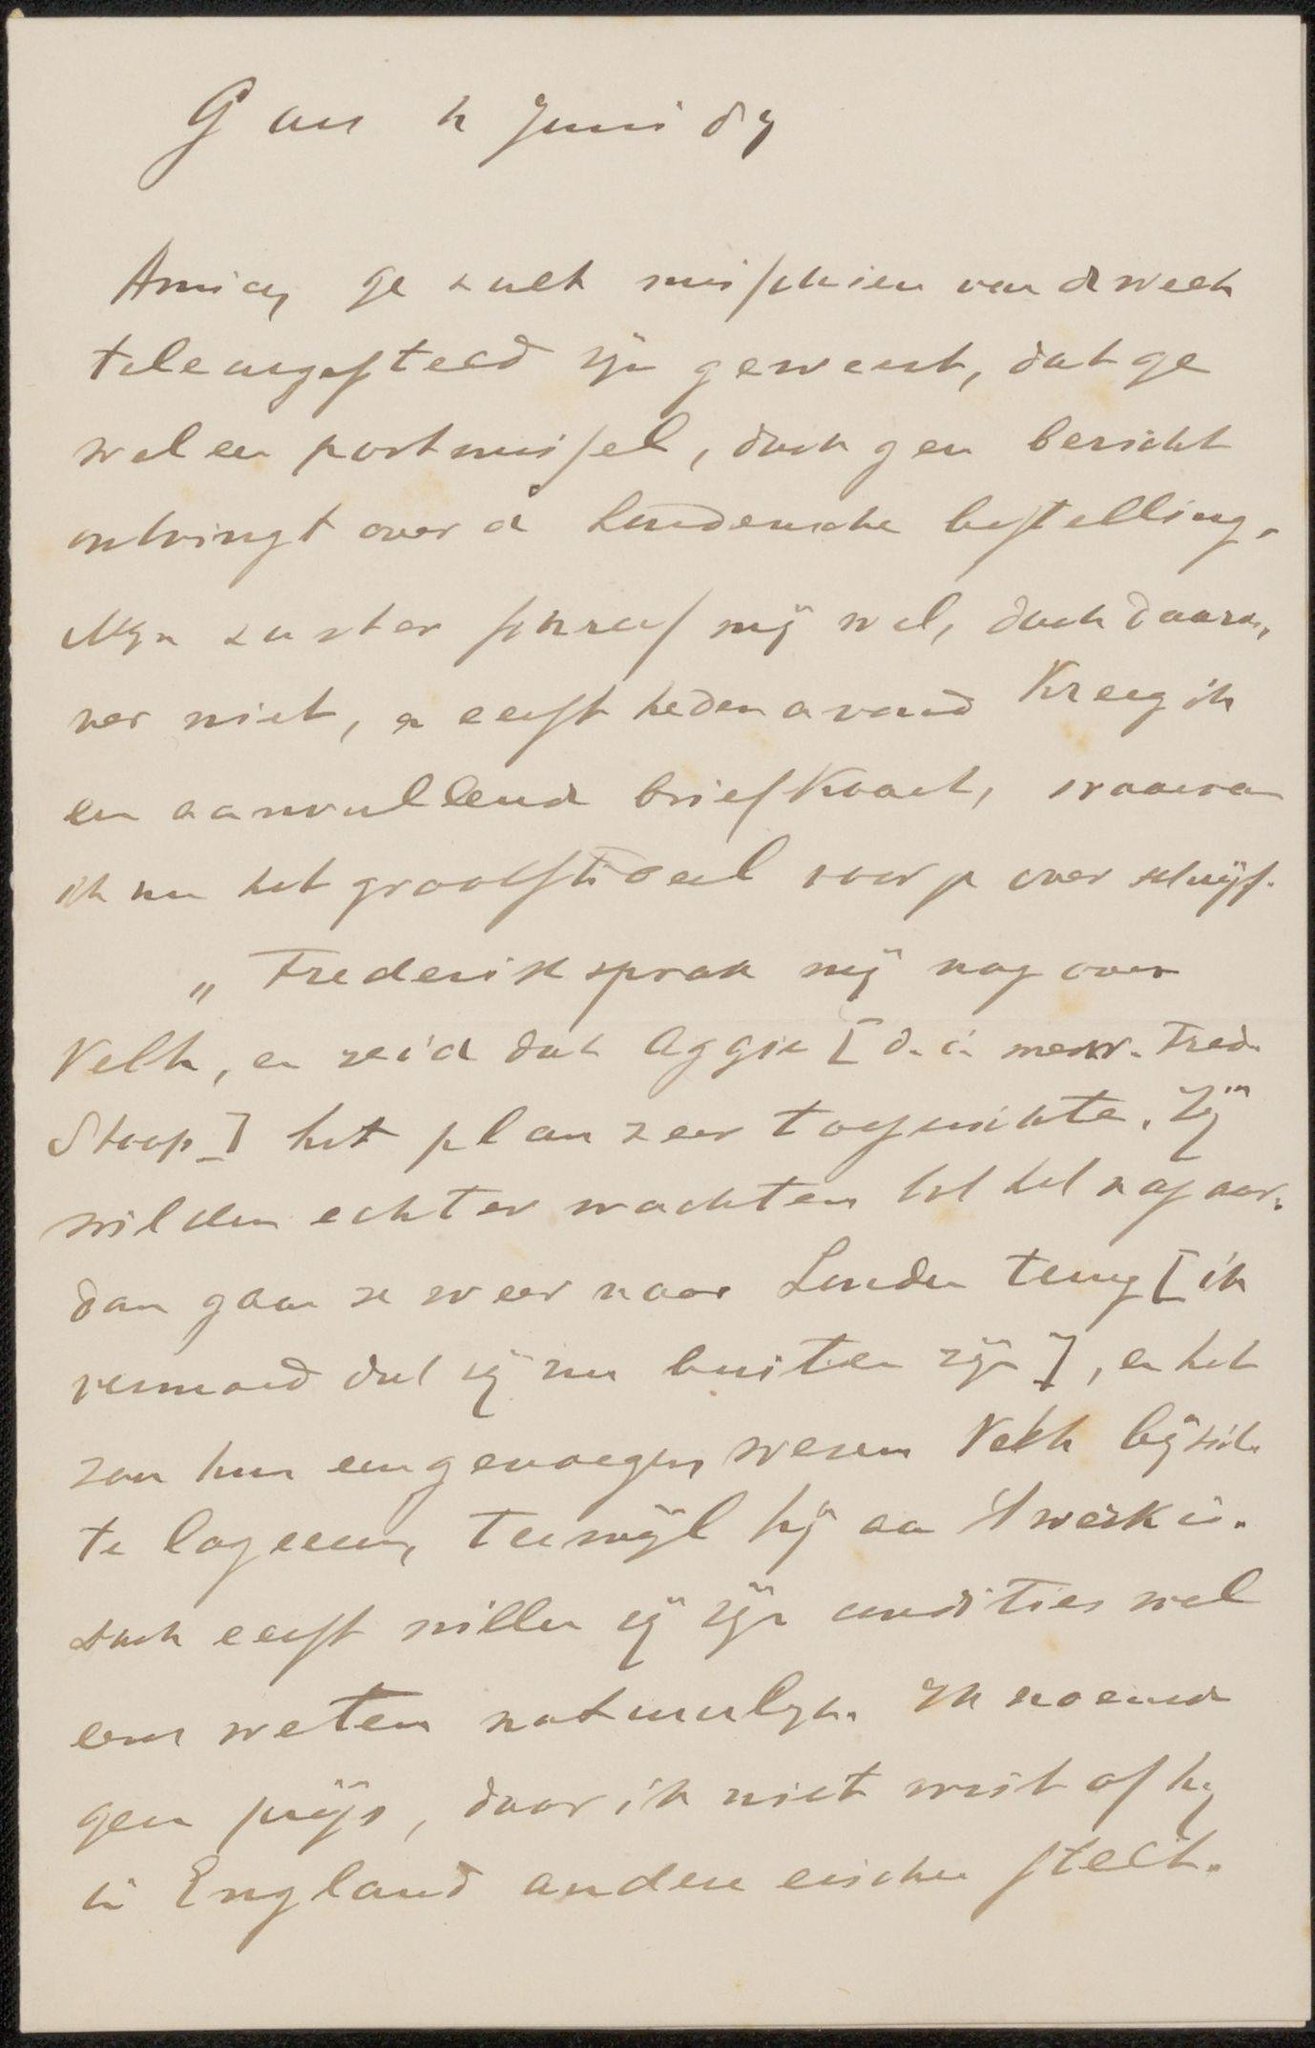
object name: letter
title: Brief aan Jan Veth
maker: chap van deventer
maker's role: kunstcriticus, scheikundige, schrijver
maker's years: 1860-1931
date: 1887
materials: ink, paper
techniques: pen, writing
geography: goes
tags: dordrecht, designer, jan veth, amsterdam, painter, print maker, draughtsman, willem witsen, the graphic arts, london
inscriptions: collector's mark: ‘RPK’, watermark